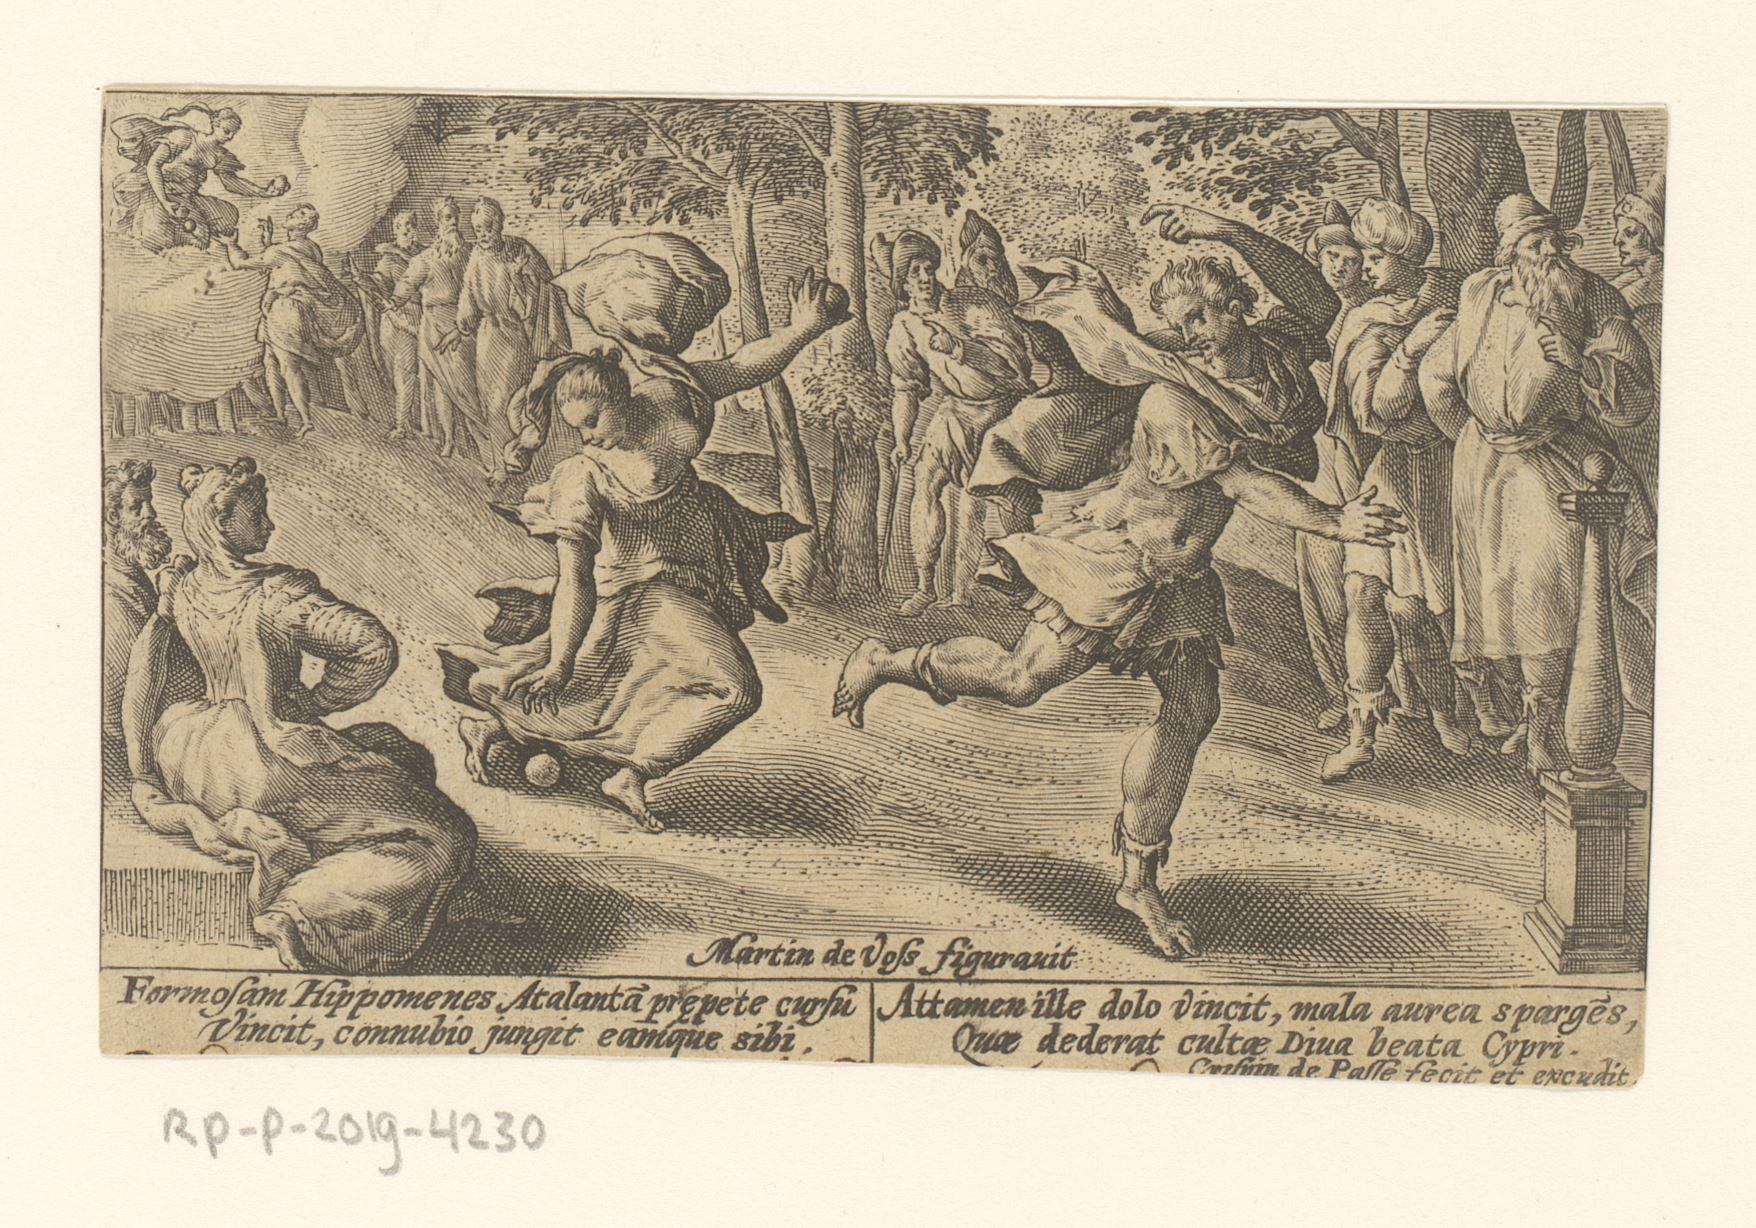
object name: print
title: Atalanta en Hippomenes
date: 1602-1604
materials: paper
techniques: engraving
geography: cologne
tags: publius ovidius naso, venus presents hippomenes with three golden apples, during the foot-race hippomenes drops the three golden apples; atalante stops to pick them up, and is thus beaten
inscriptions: collector's mark: Lugt 2228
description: De hardloopwedstrijd tussen de ongeslagen Atalanta en haar aanbidder Hippomenes. Hippomenes laat drie gouden appels vallen, Atalanta kan de verleiding om ze op te rapen niet weerstaan en verliest de wedstrijd. Op de achtergrond ontvangt Hippomenes de drie gouden appels van Venus. In de marge een vierregelig onderschrift, in twee kolommen, in het Latijn.